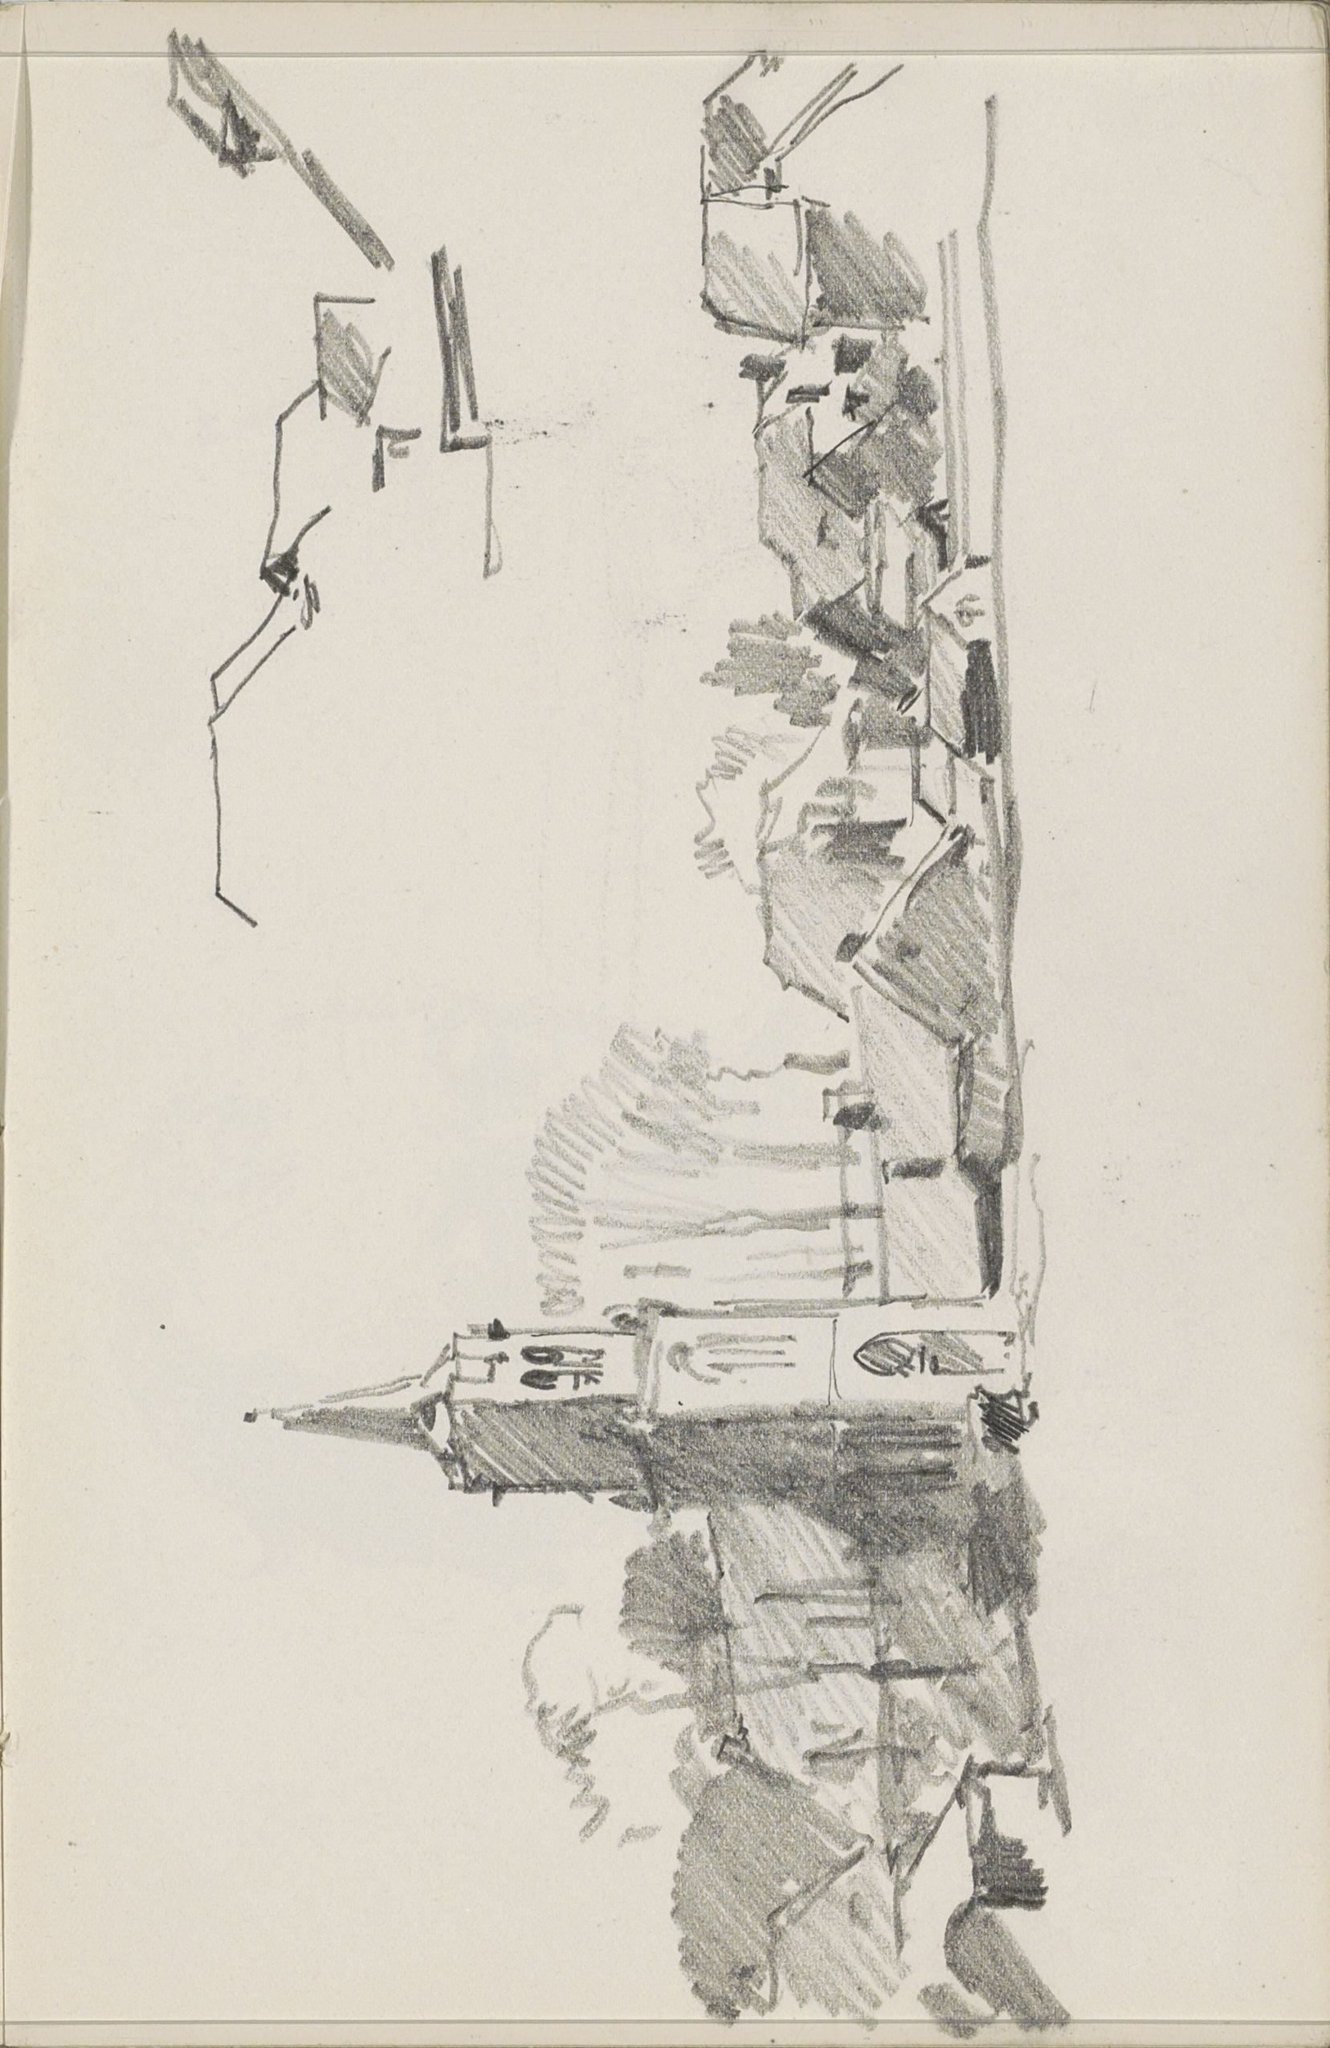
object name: sketchbook leaf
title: Dorpsgezicht met een kerktoren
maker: cornelis vreedenburgh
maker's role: draughtsman, print maker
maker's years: 1880-1946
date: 1890-1946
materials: paper, pencil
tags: village, church (exterior)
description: Blad 3 recto uit een schetsboek met 41 bladen.